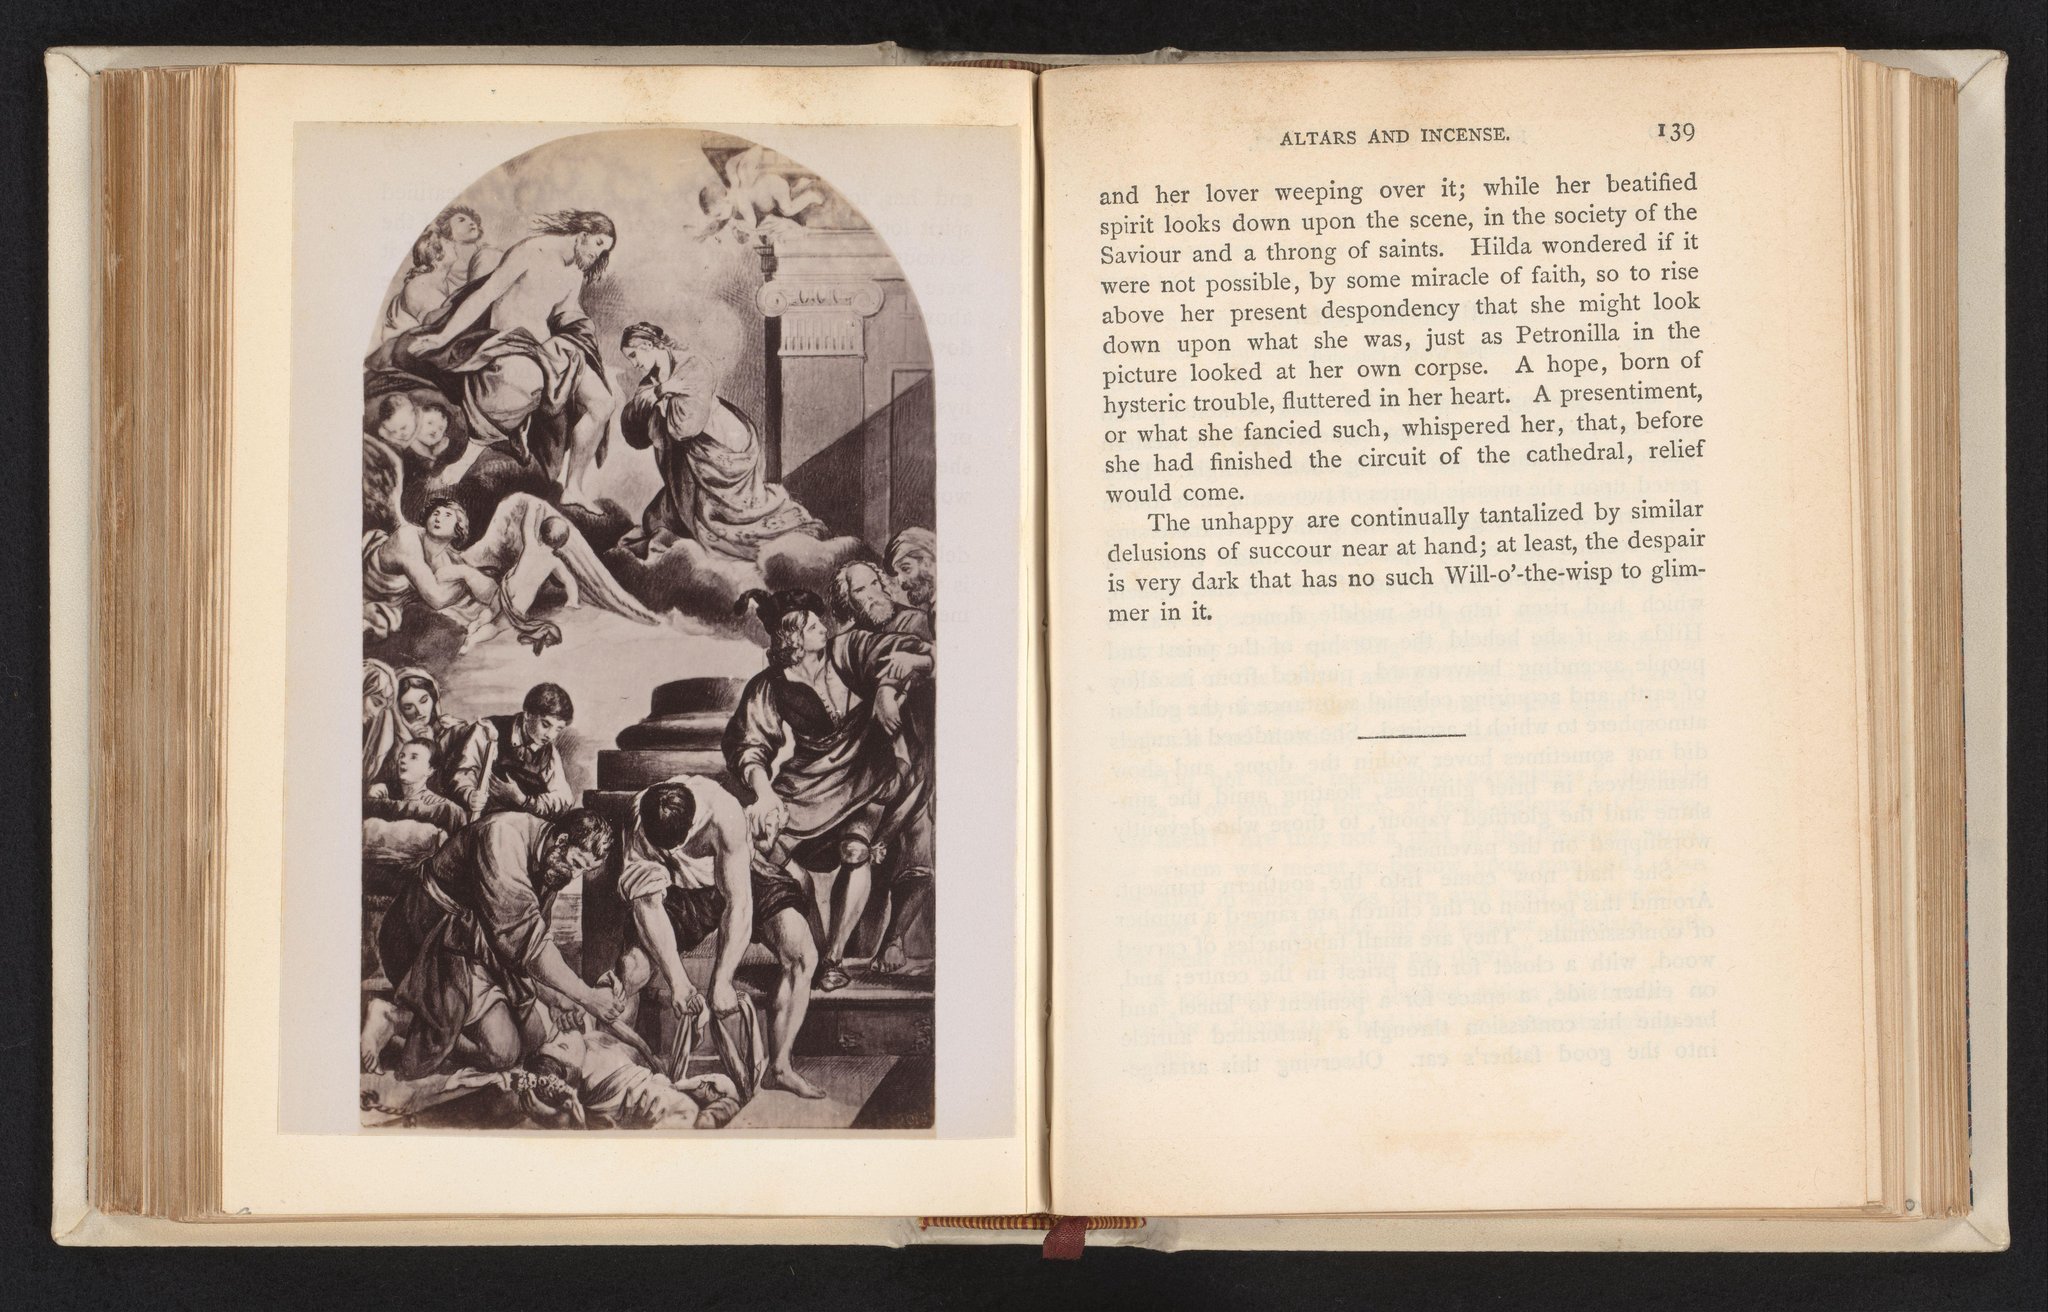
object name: photograph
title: Fotoreproductie van een tekening naar een schilderij door Guercino, voorstellend de begrafenis van Petronella van Rome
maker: Anonymous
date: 1850-1860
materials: photographic support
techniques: albumen print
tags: the virgin and martyr petronilla